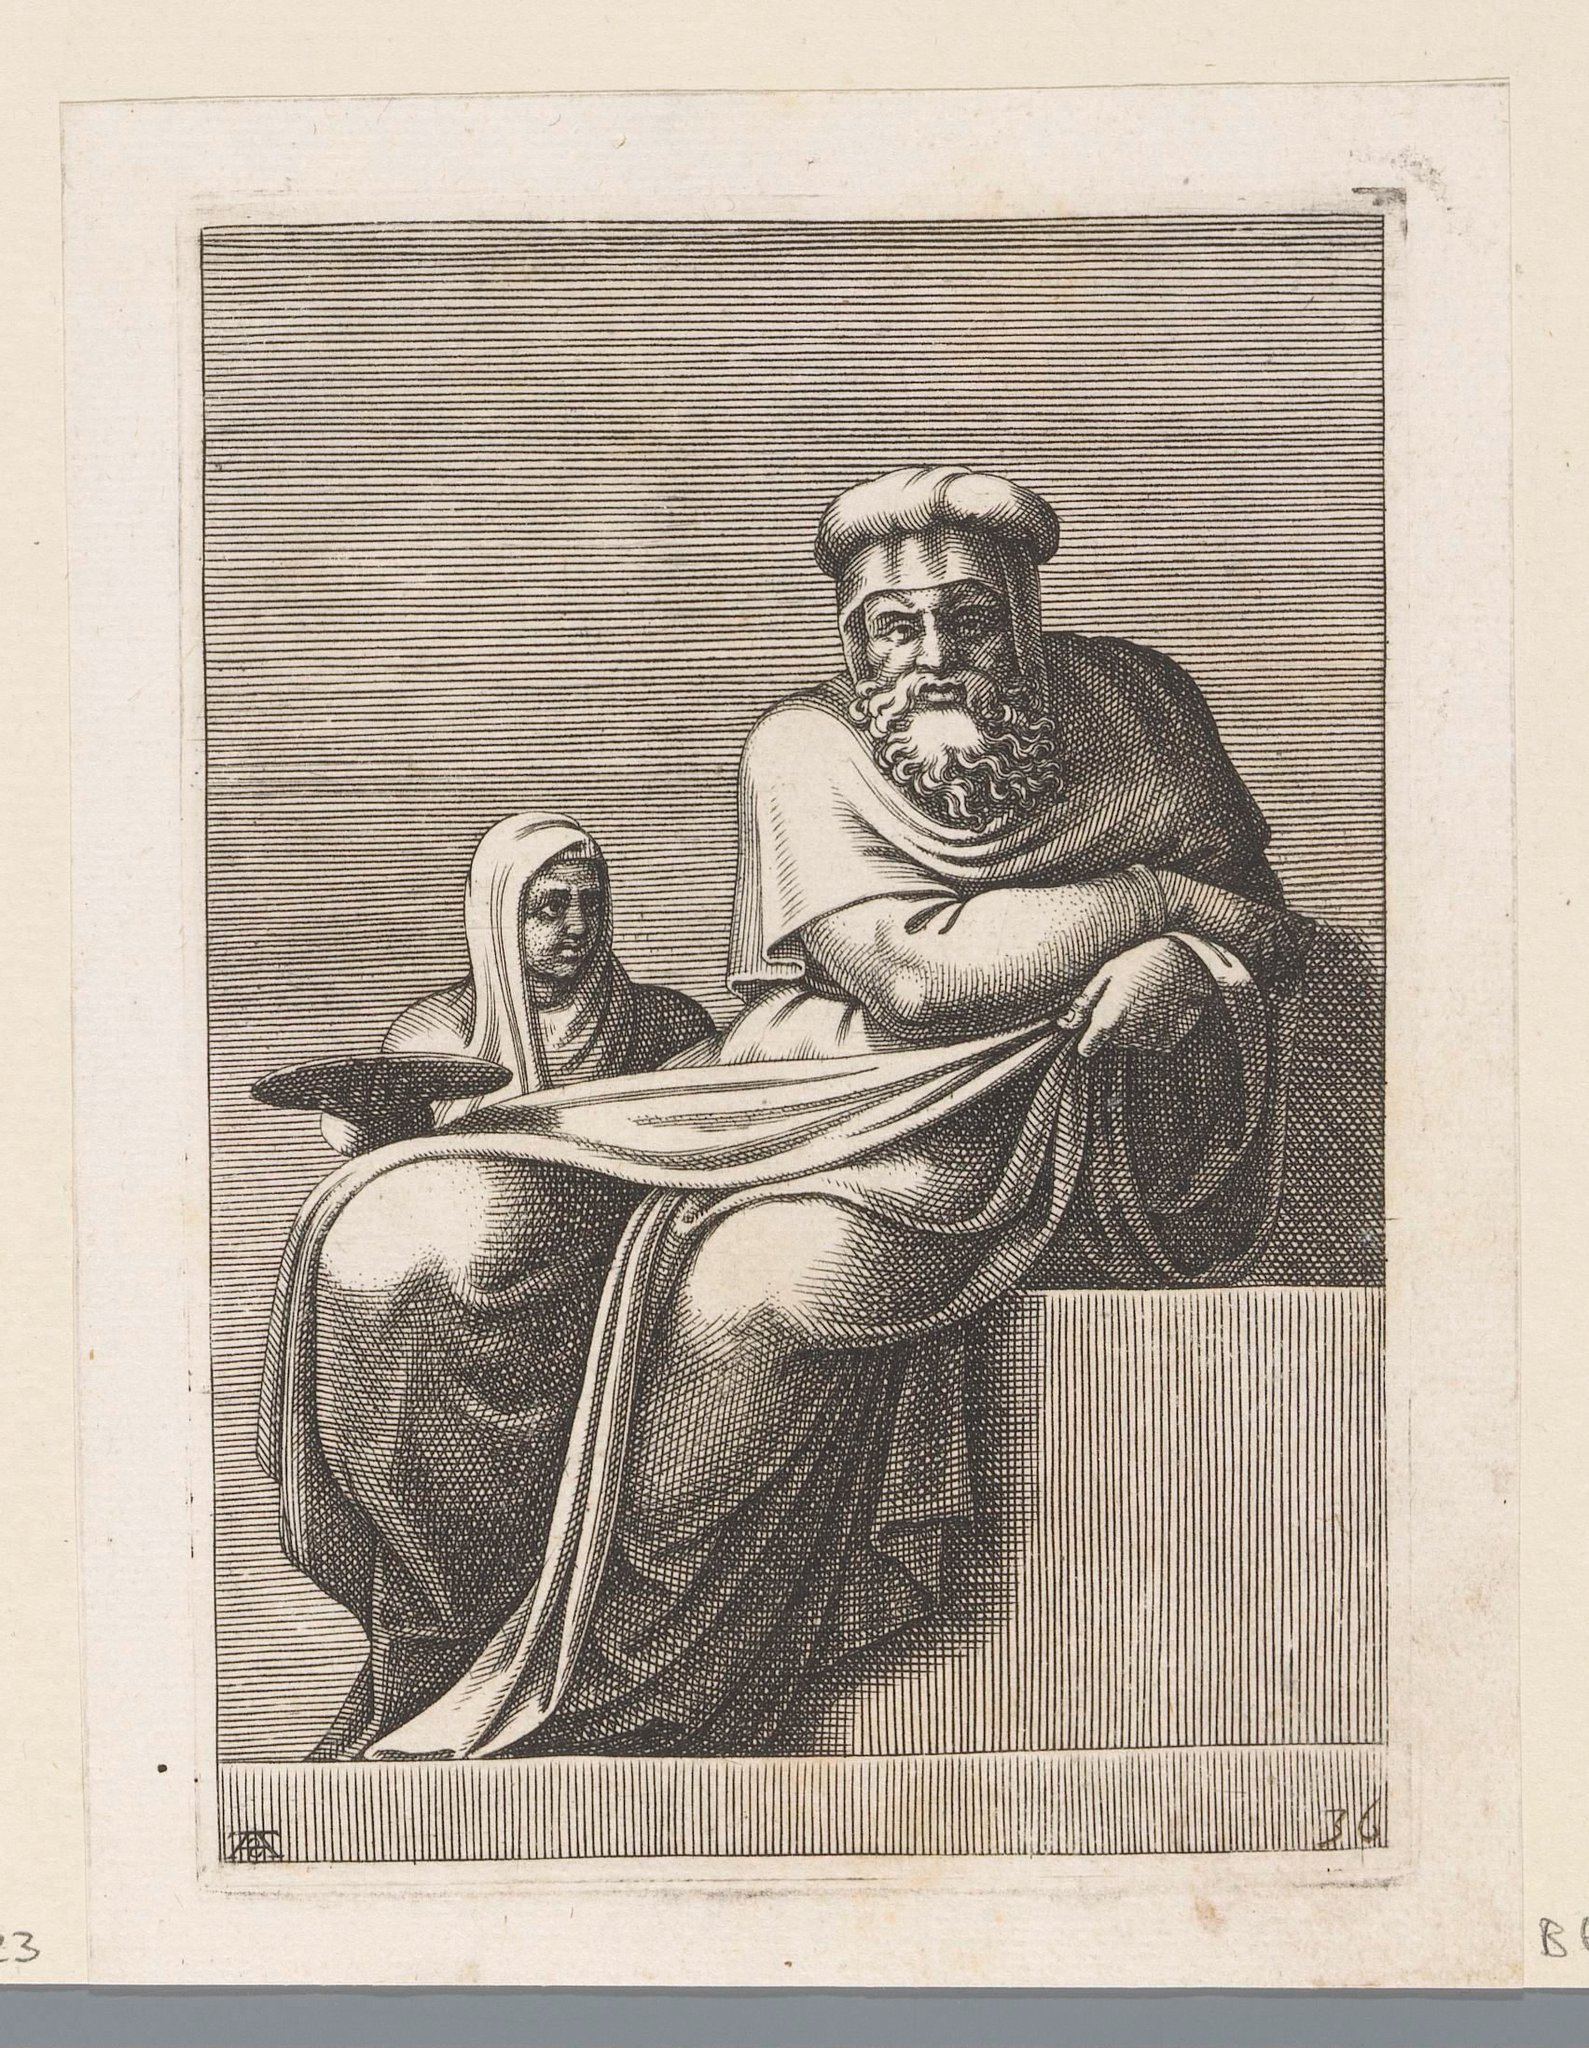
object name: print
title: Oude man met bediende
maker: adamo scultori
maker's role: painter, print maker, sculptor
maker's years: 1530-1585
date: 1585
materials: paper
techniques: engraving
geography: italy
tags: house personnel, servants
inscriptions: collector's mark: Lugt 240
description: Deze prent maakt deel uit van een serie bestaande uit een titelprent en 72 prenten naar schilderingen door Michelangelo in de Sixtijnse Kapel in het Vaticaan.